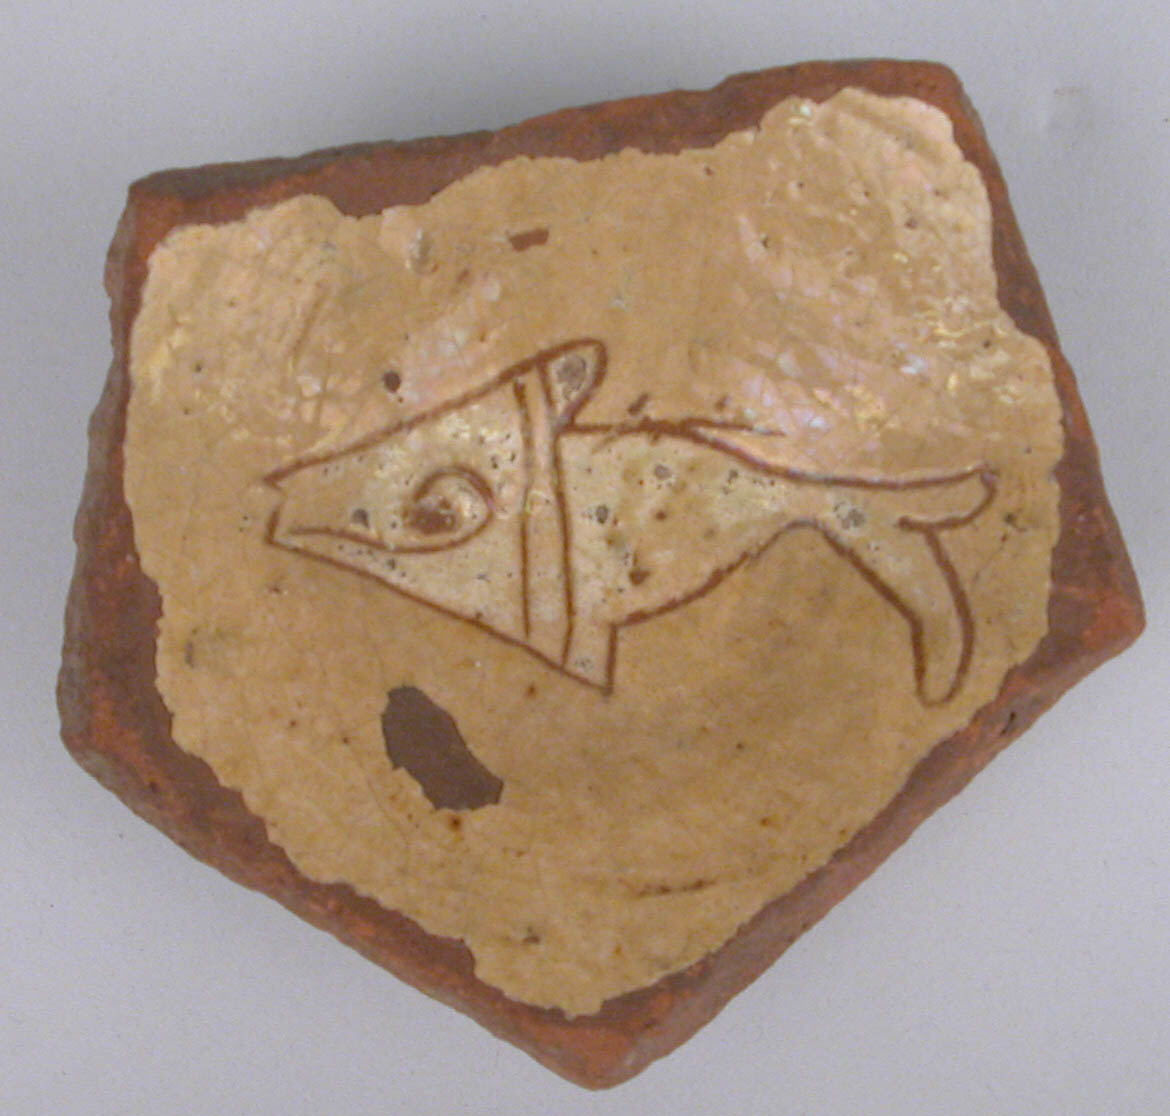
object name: fragment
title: Ceramic Fragment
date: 1301-1500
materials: earthenware, glaze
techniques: coloring, incising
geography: egypt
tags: fish